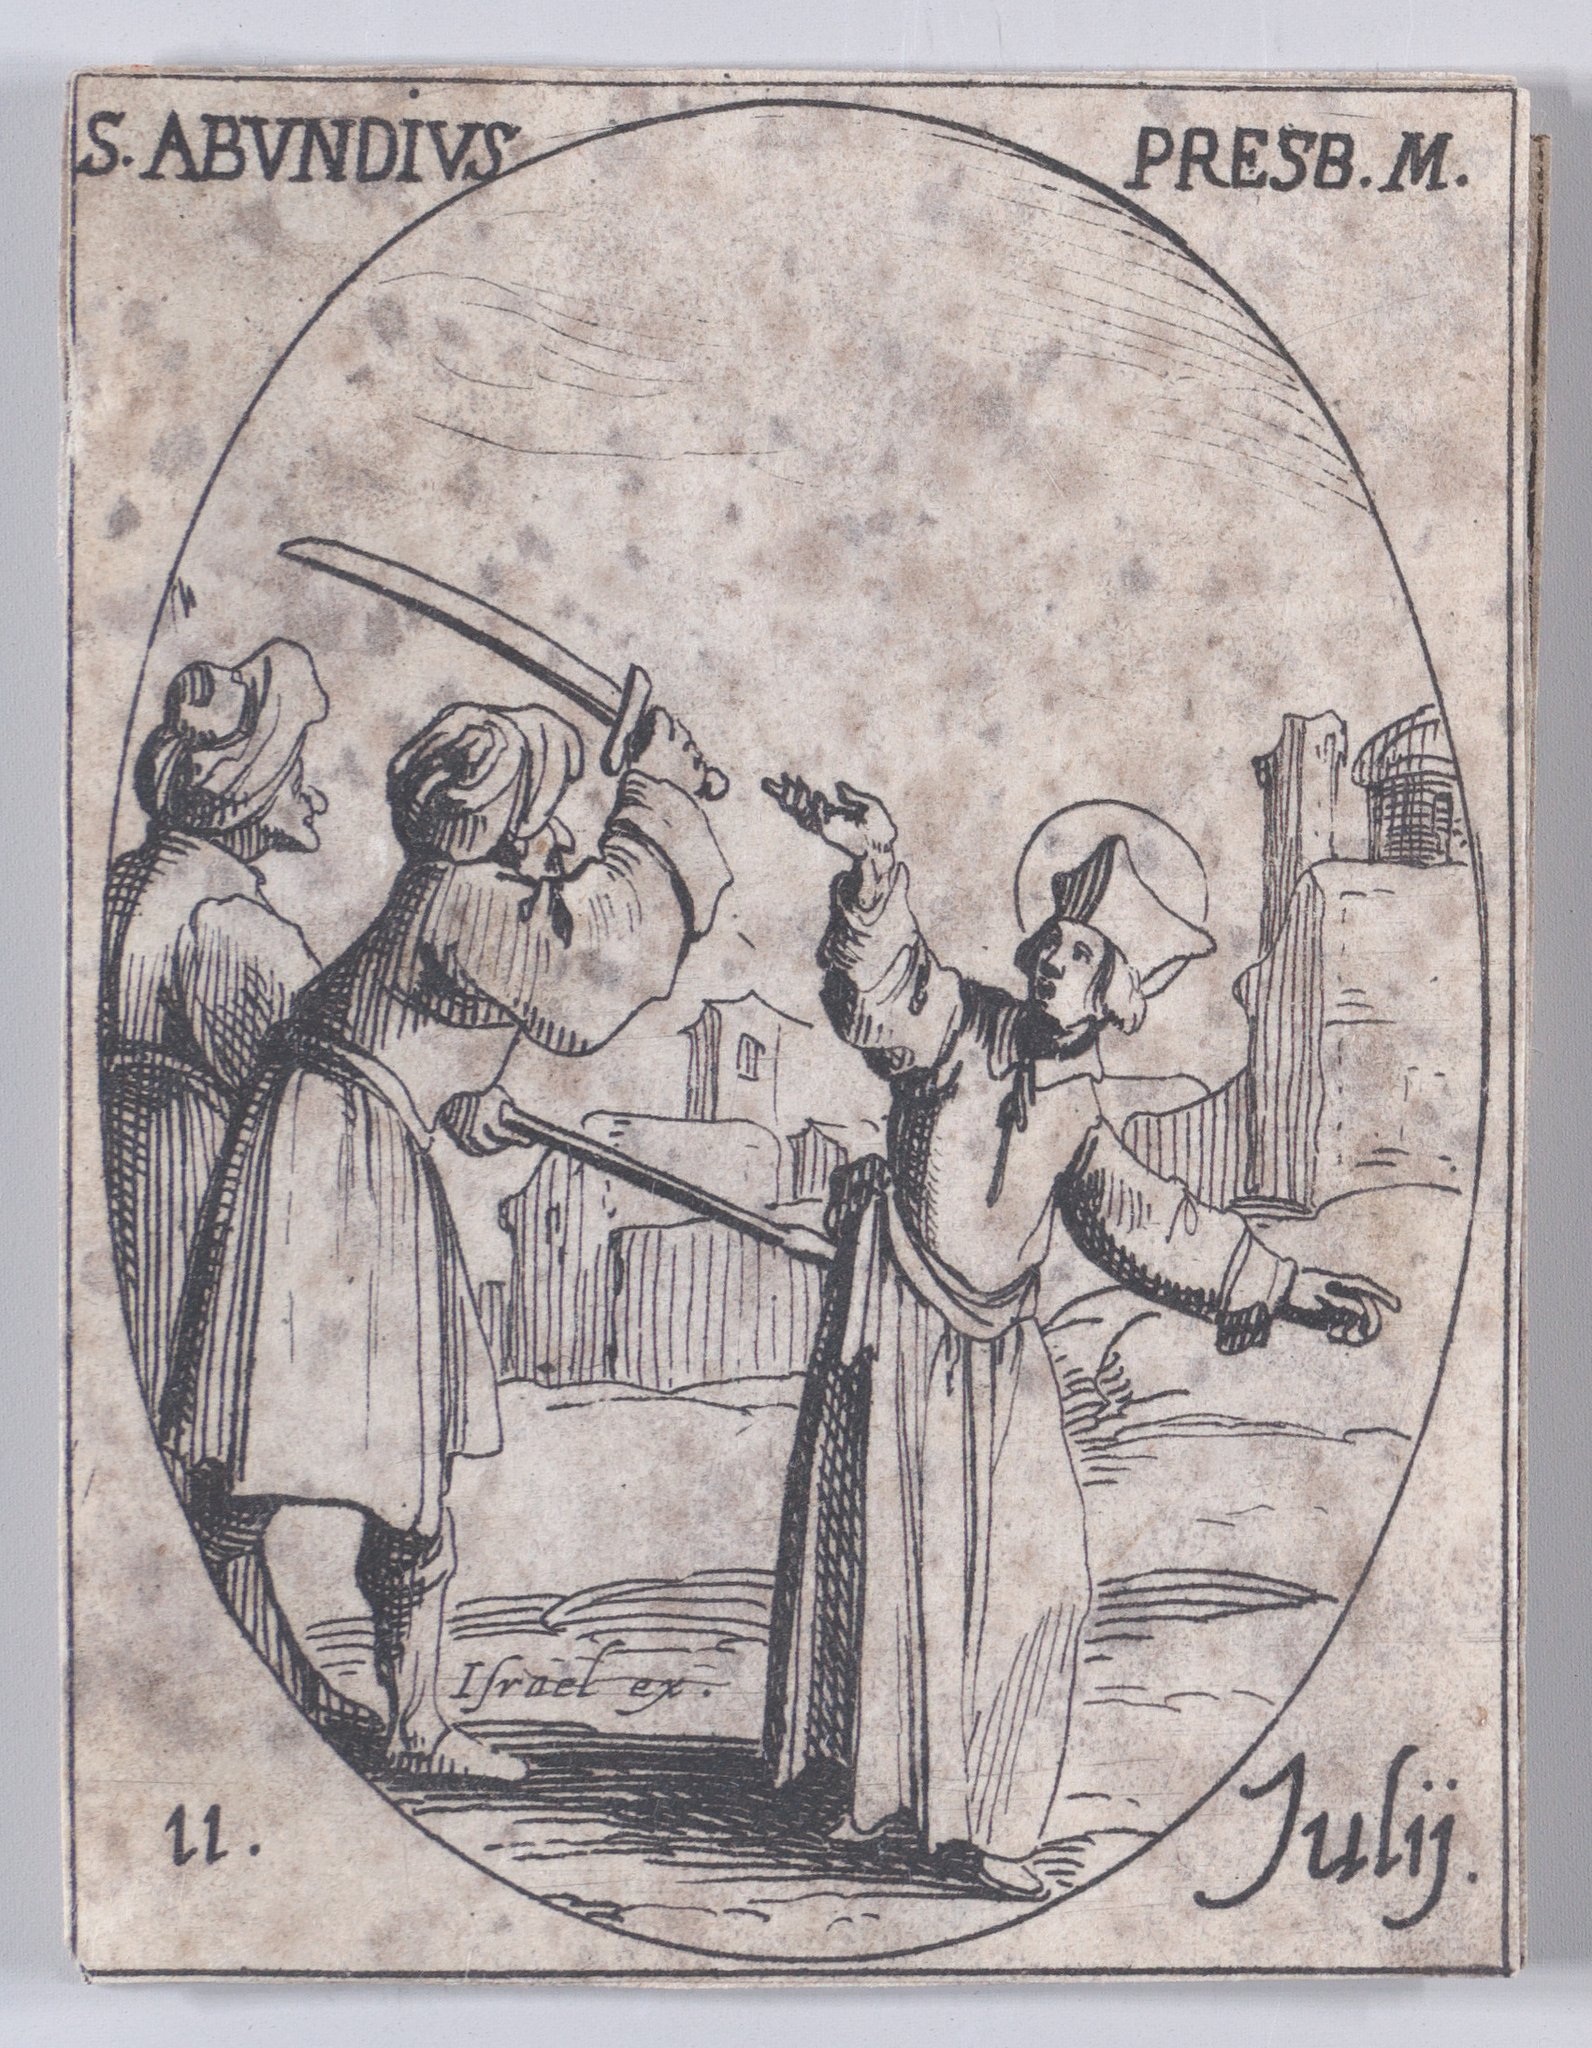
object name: print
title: S. Abondie, prêtre et martyr (St. Abundius, Priest and Martyr), July 11th, from "Les Images De Tous Les Saincts et Saintes de L'Année" (Images of All of the Saints and Religious Events of the Year)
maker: jacques callot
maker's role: artist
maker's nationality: french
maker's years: 1592-1635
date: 1636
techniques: etching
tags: men,saints